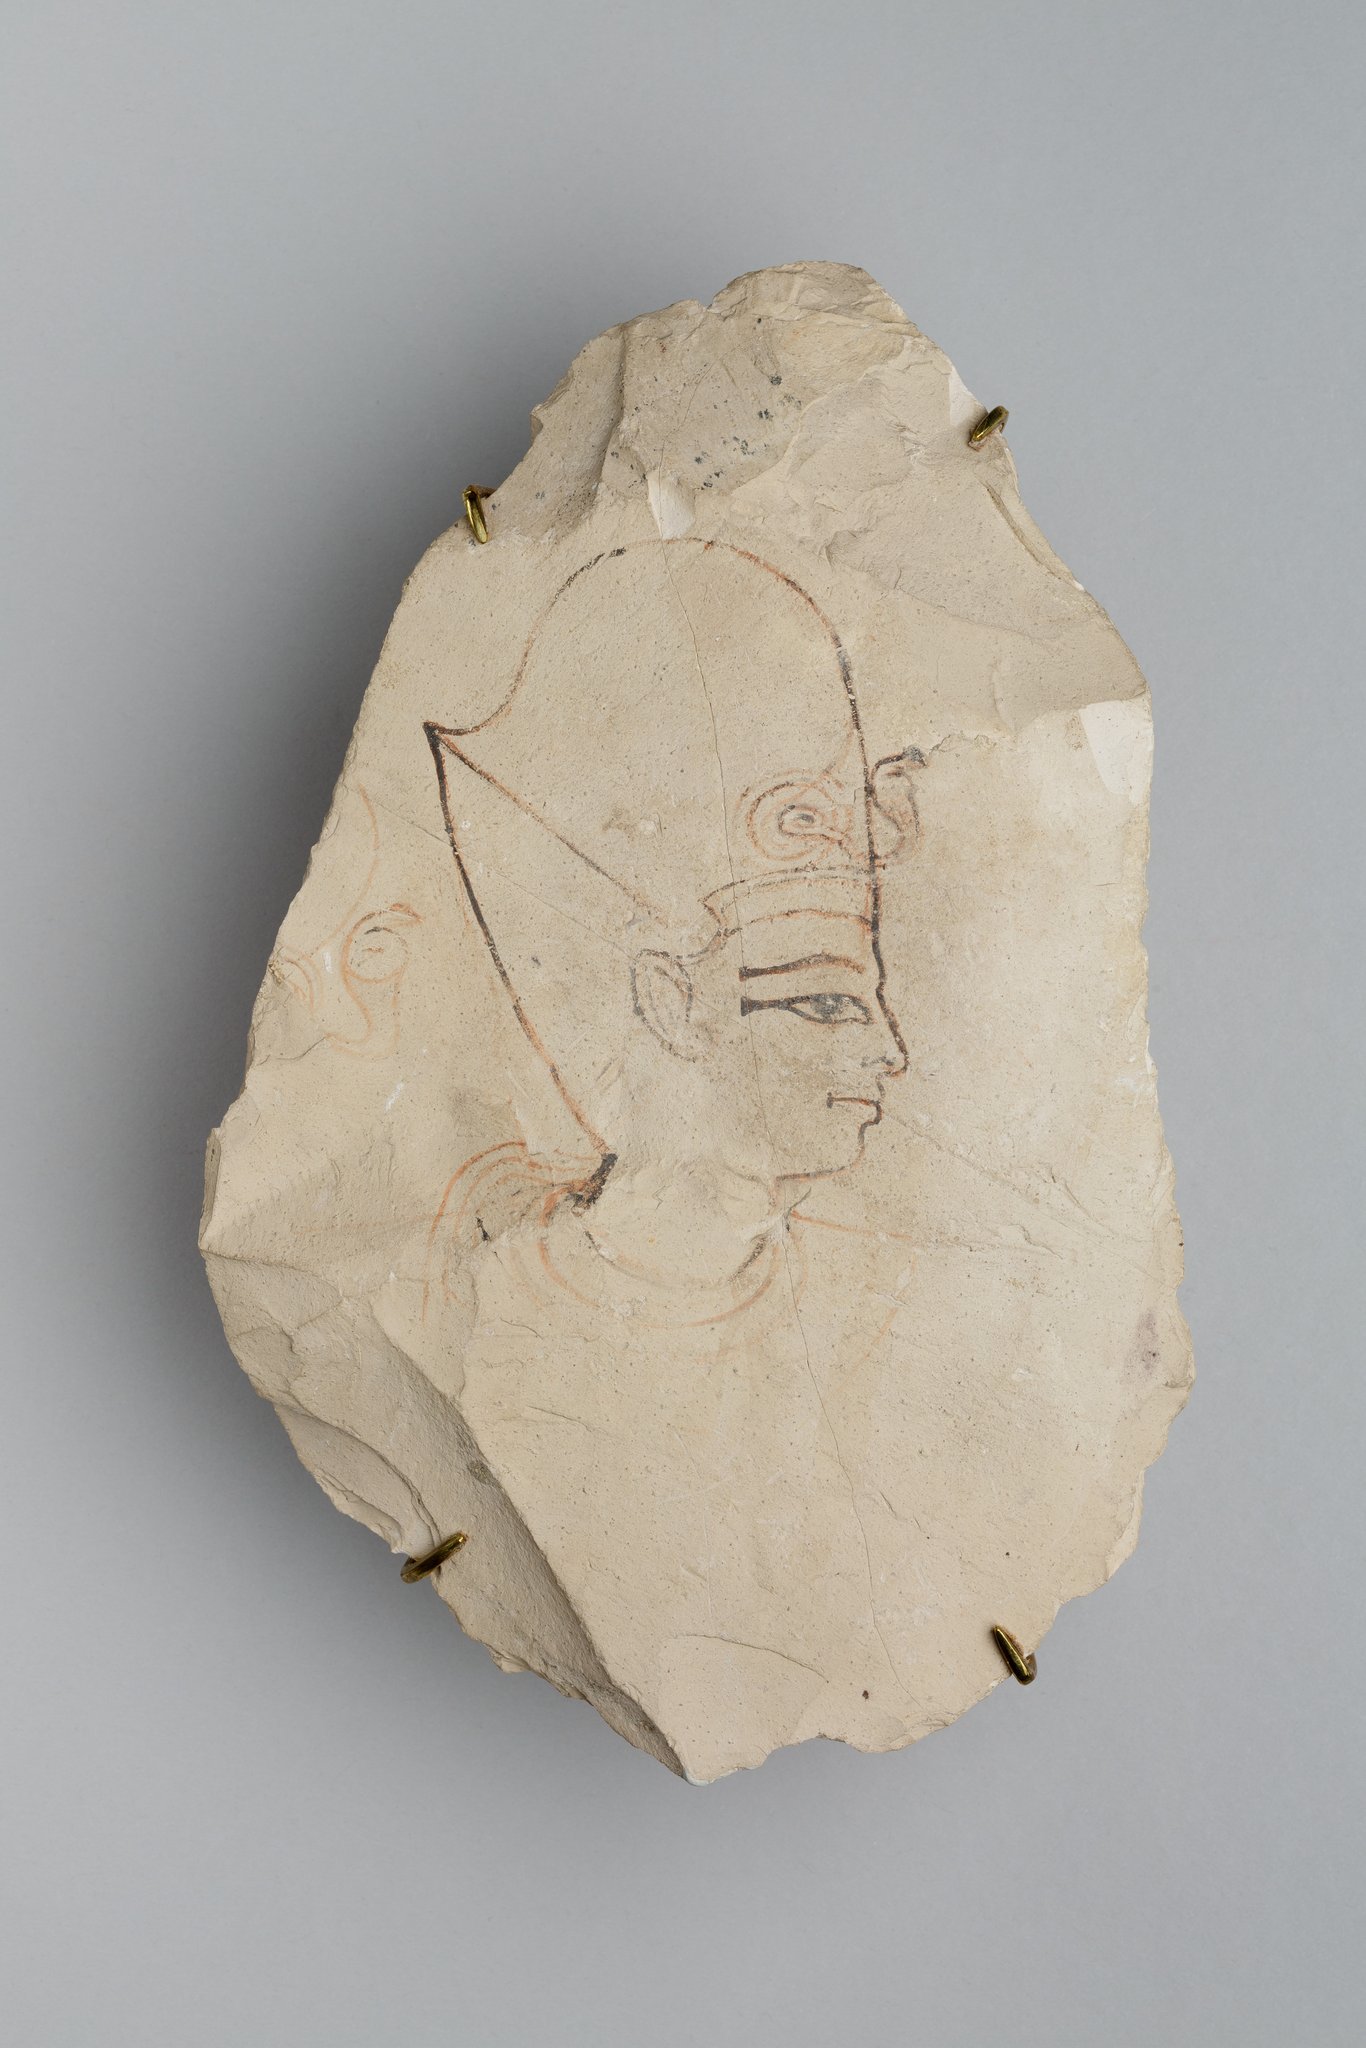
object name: ostracon, figured, king's head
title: Ostracon Depicting a King's Head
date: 1295-1070 BCE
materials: ink, limestone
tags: heads,men